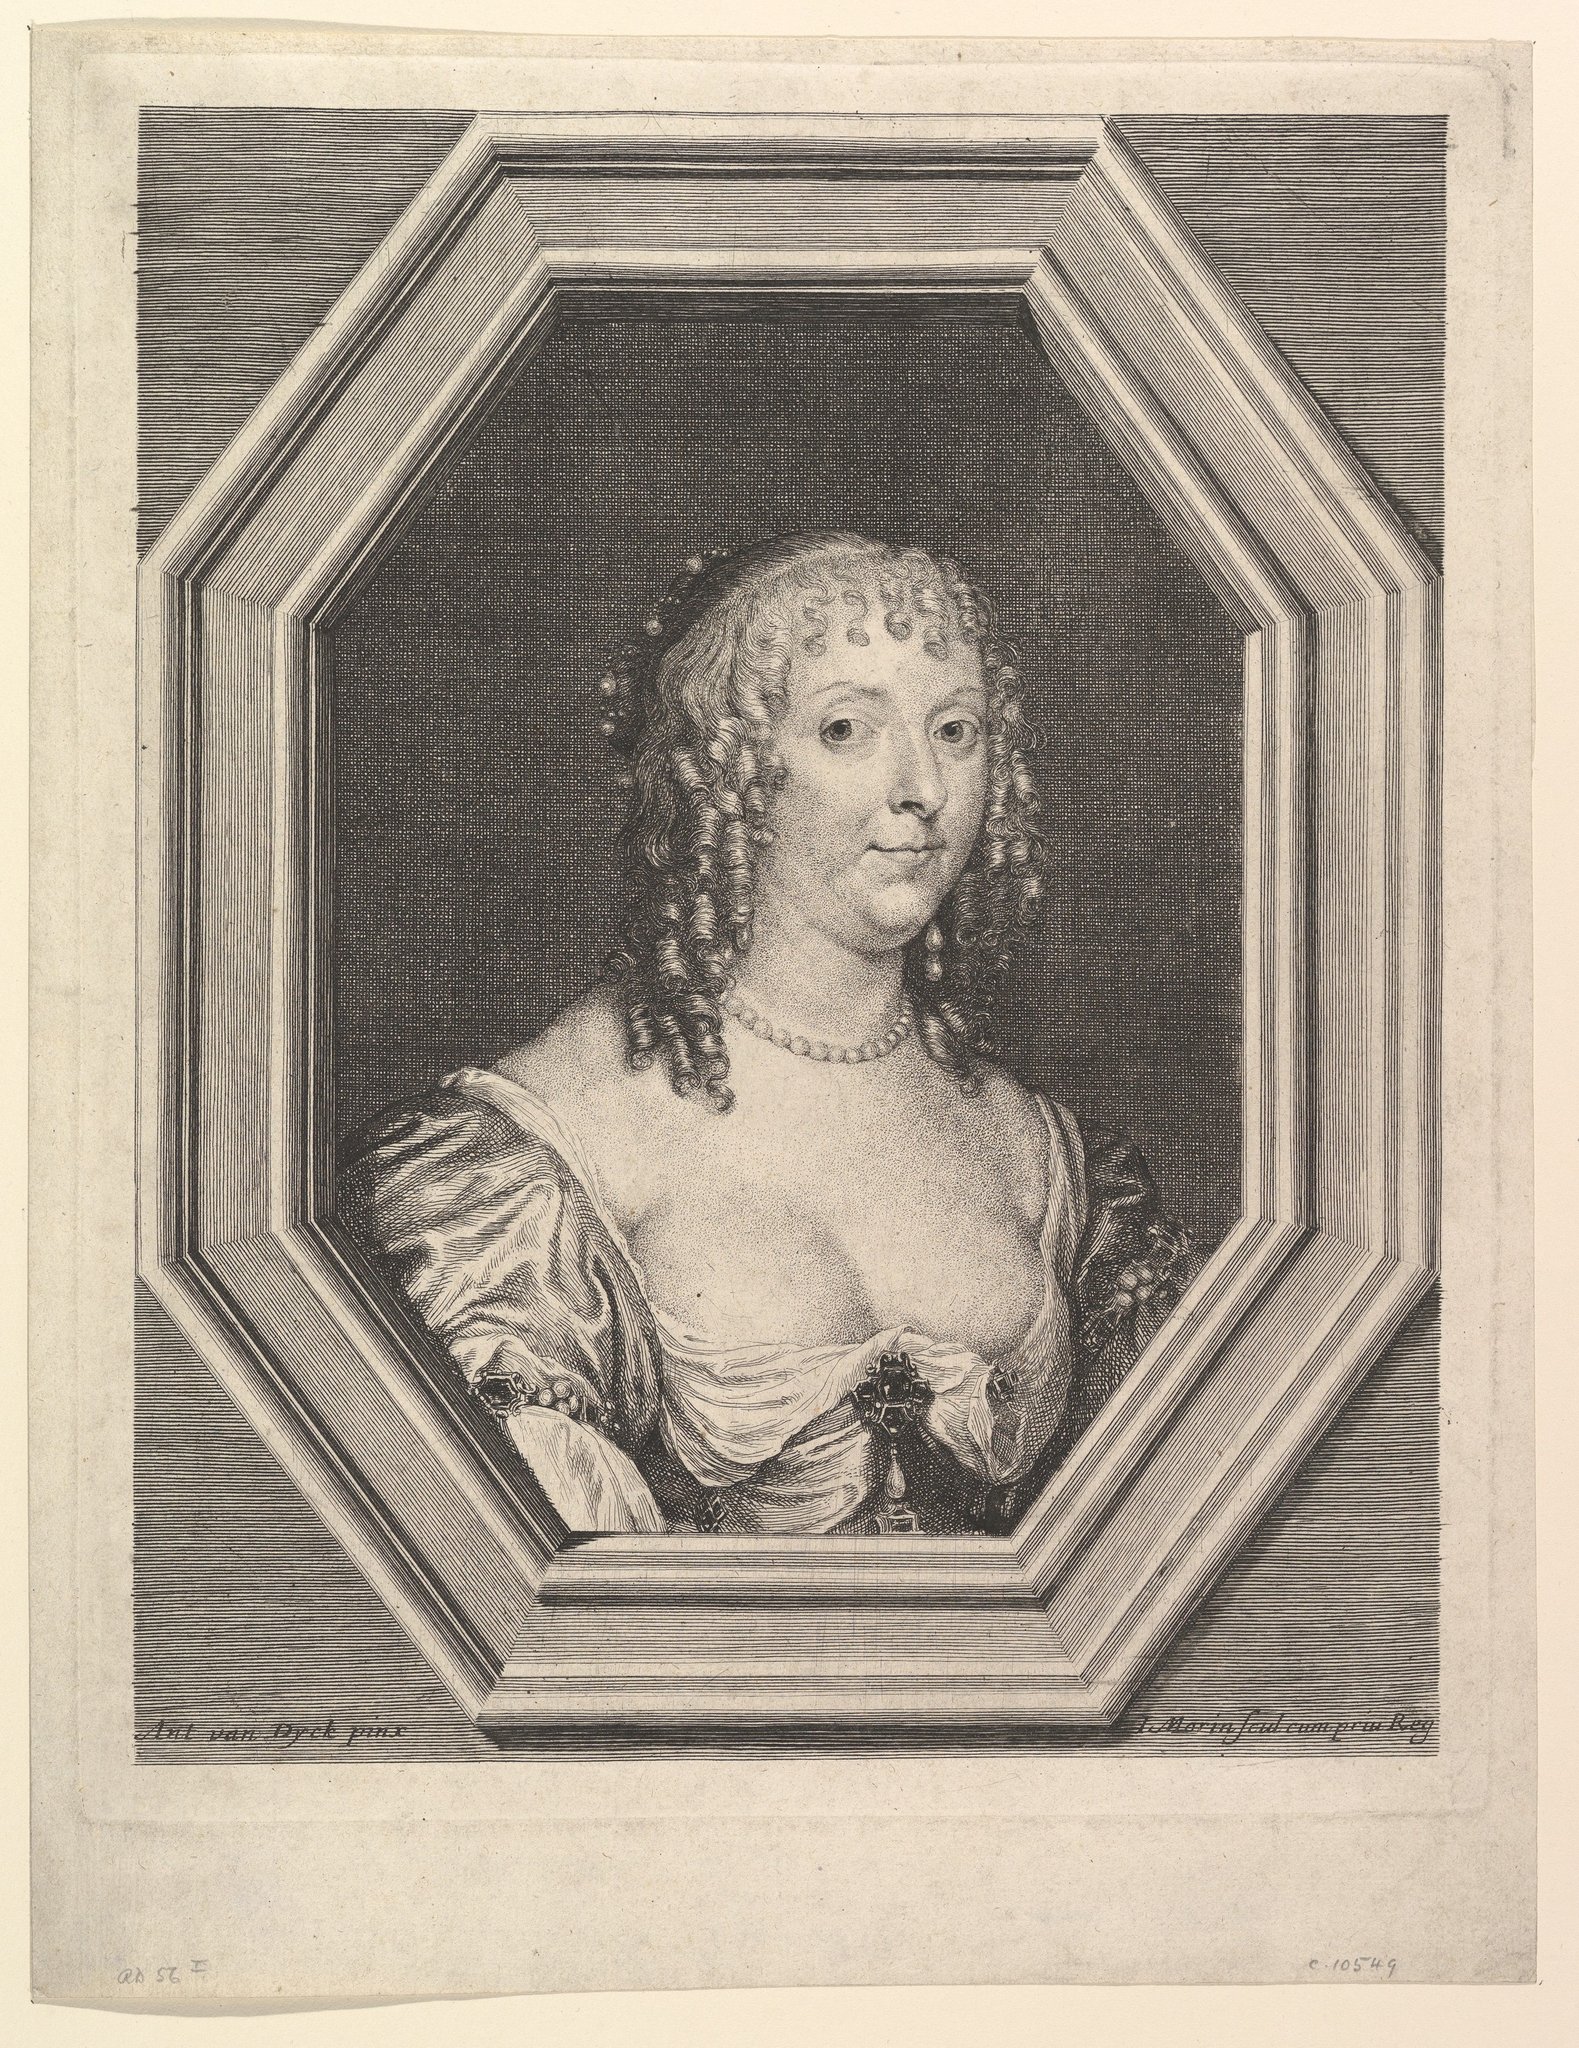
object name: print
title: Anne-Sophie Herbert, comtesse de Carnarvon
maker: jean morin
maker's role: artist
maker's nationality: french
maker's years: 1605-1650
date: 1605-1650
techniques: etching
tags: portraits,women